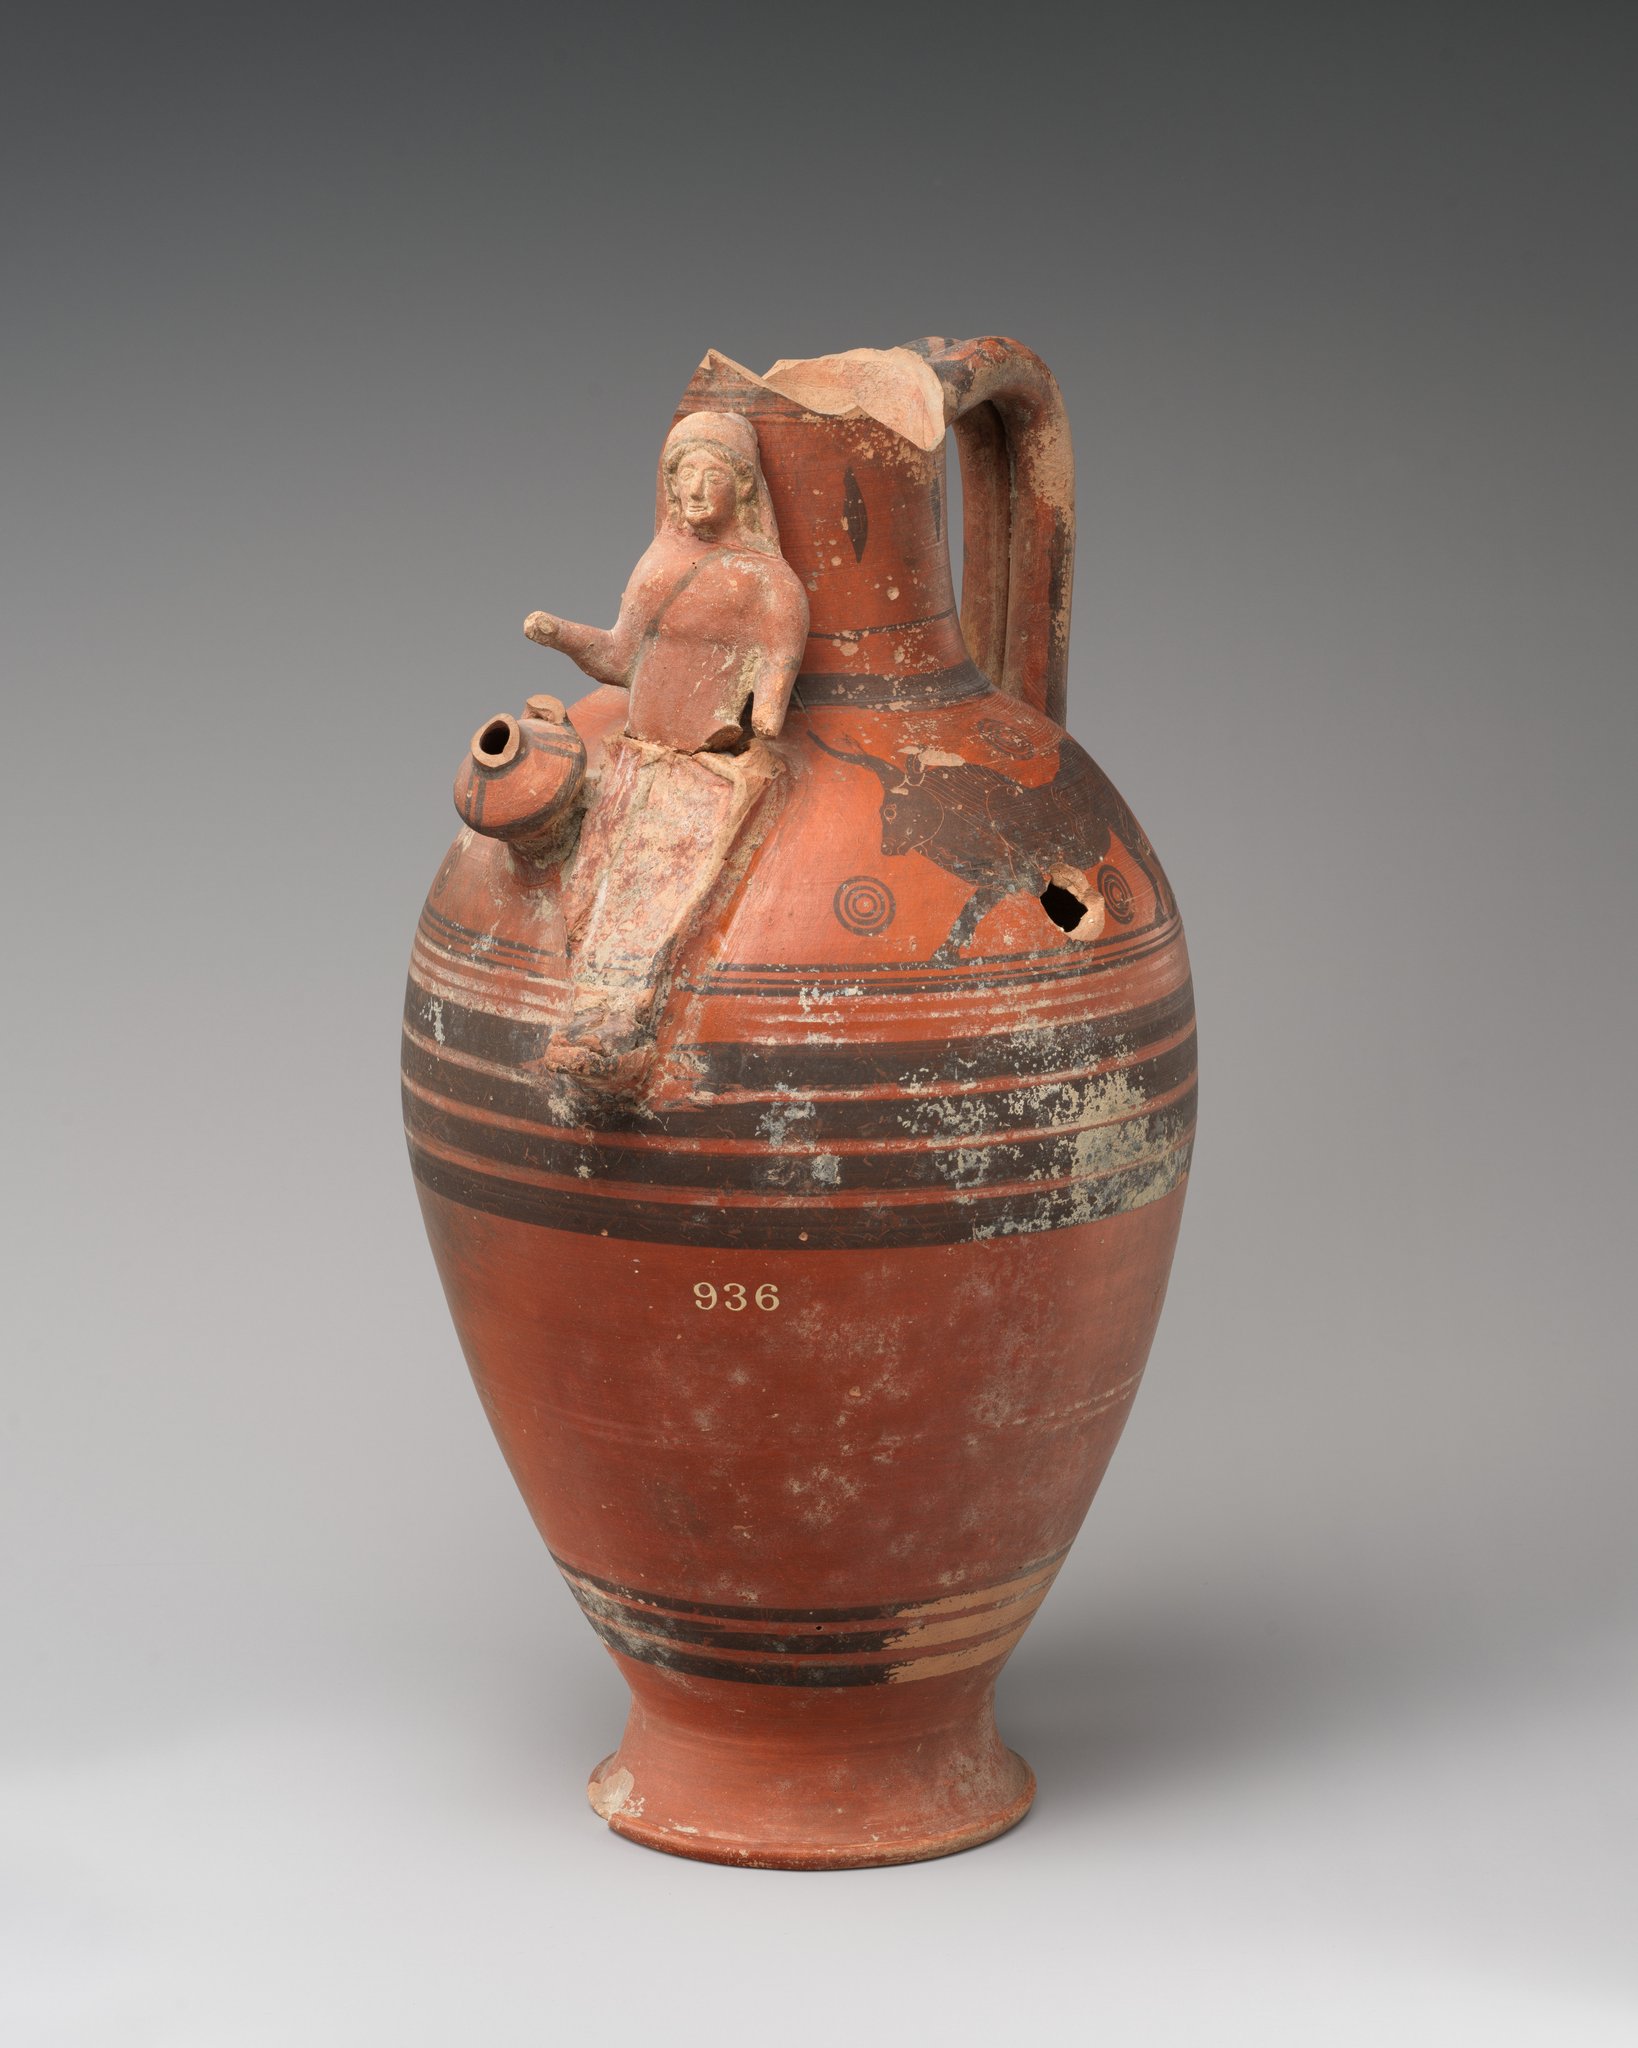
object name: jug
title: Terracotta jug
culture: cypriot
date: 600-480 BCE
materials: terracotta